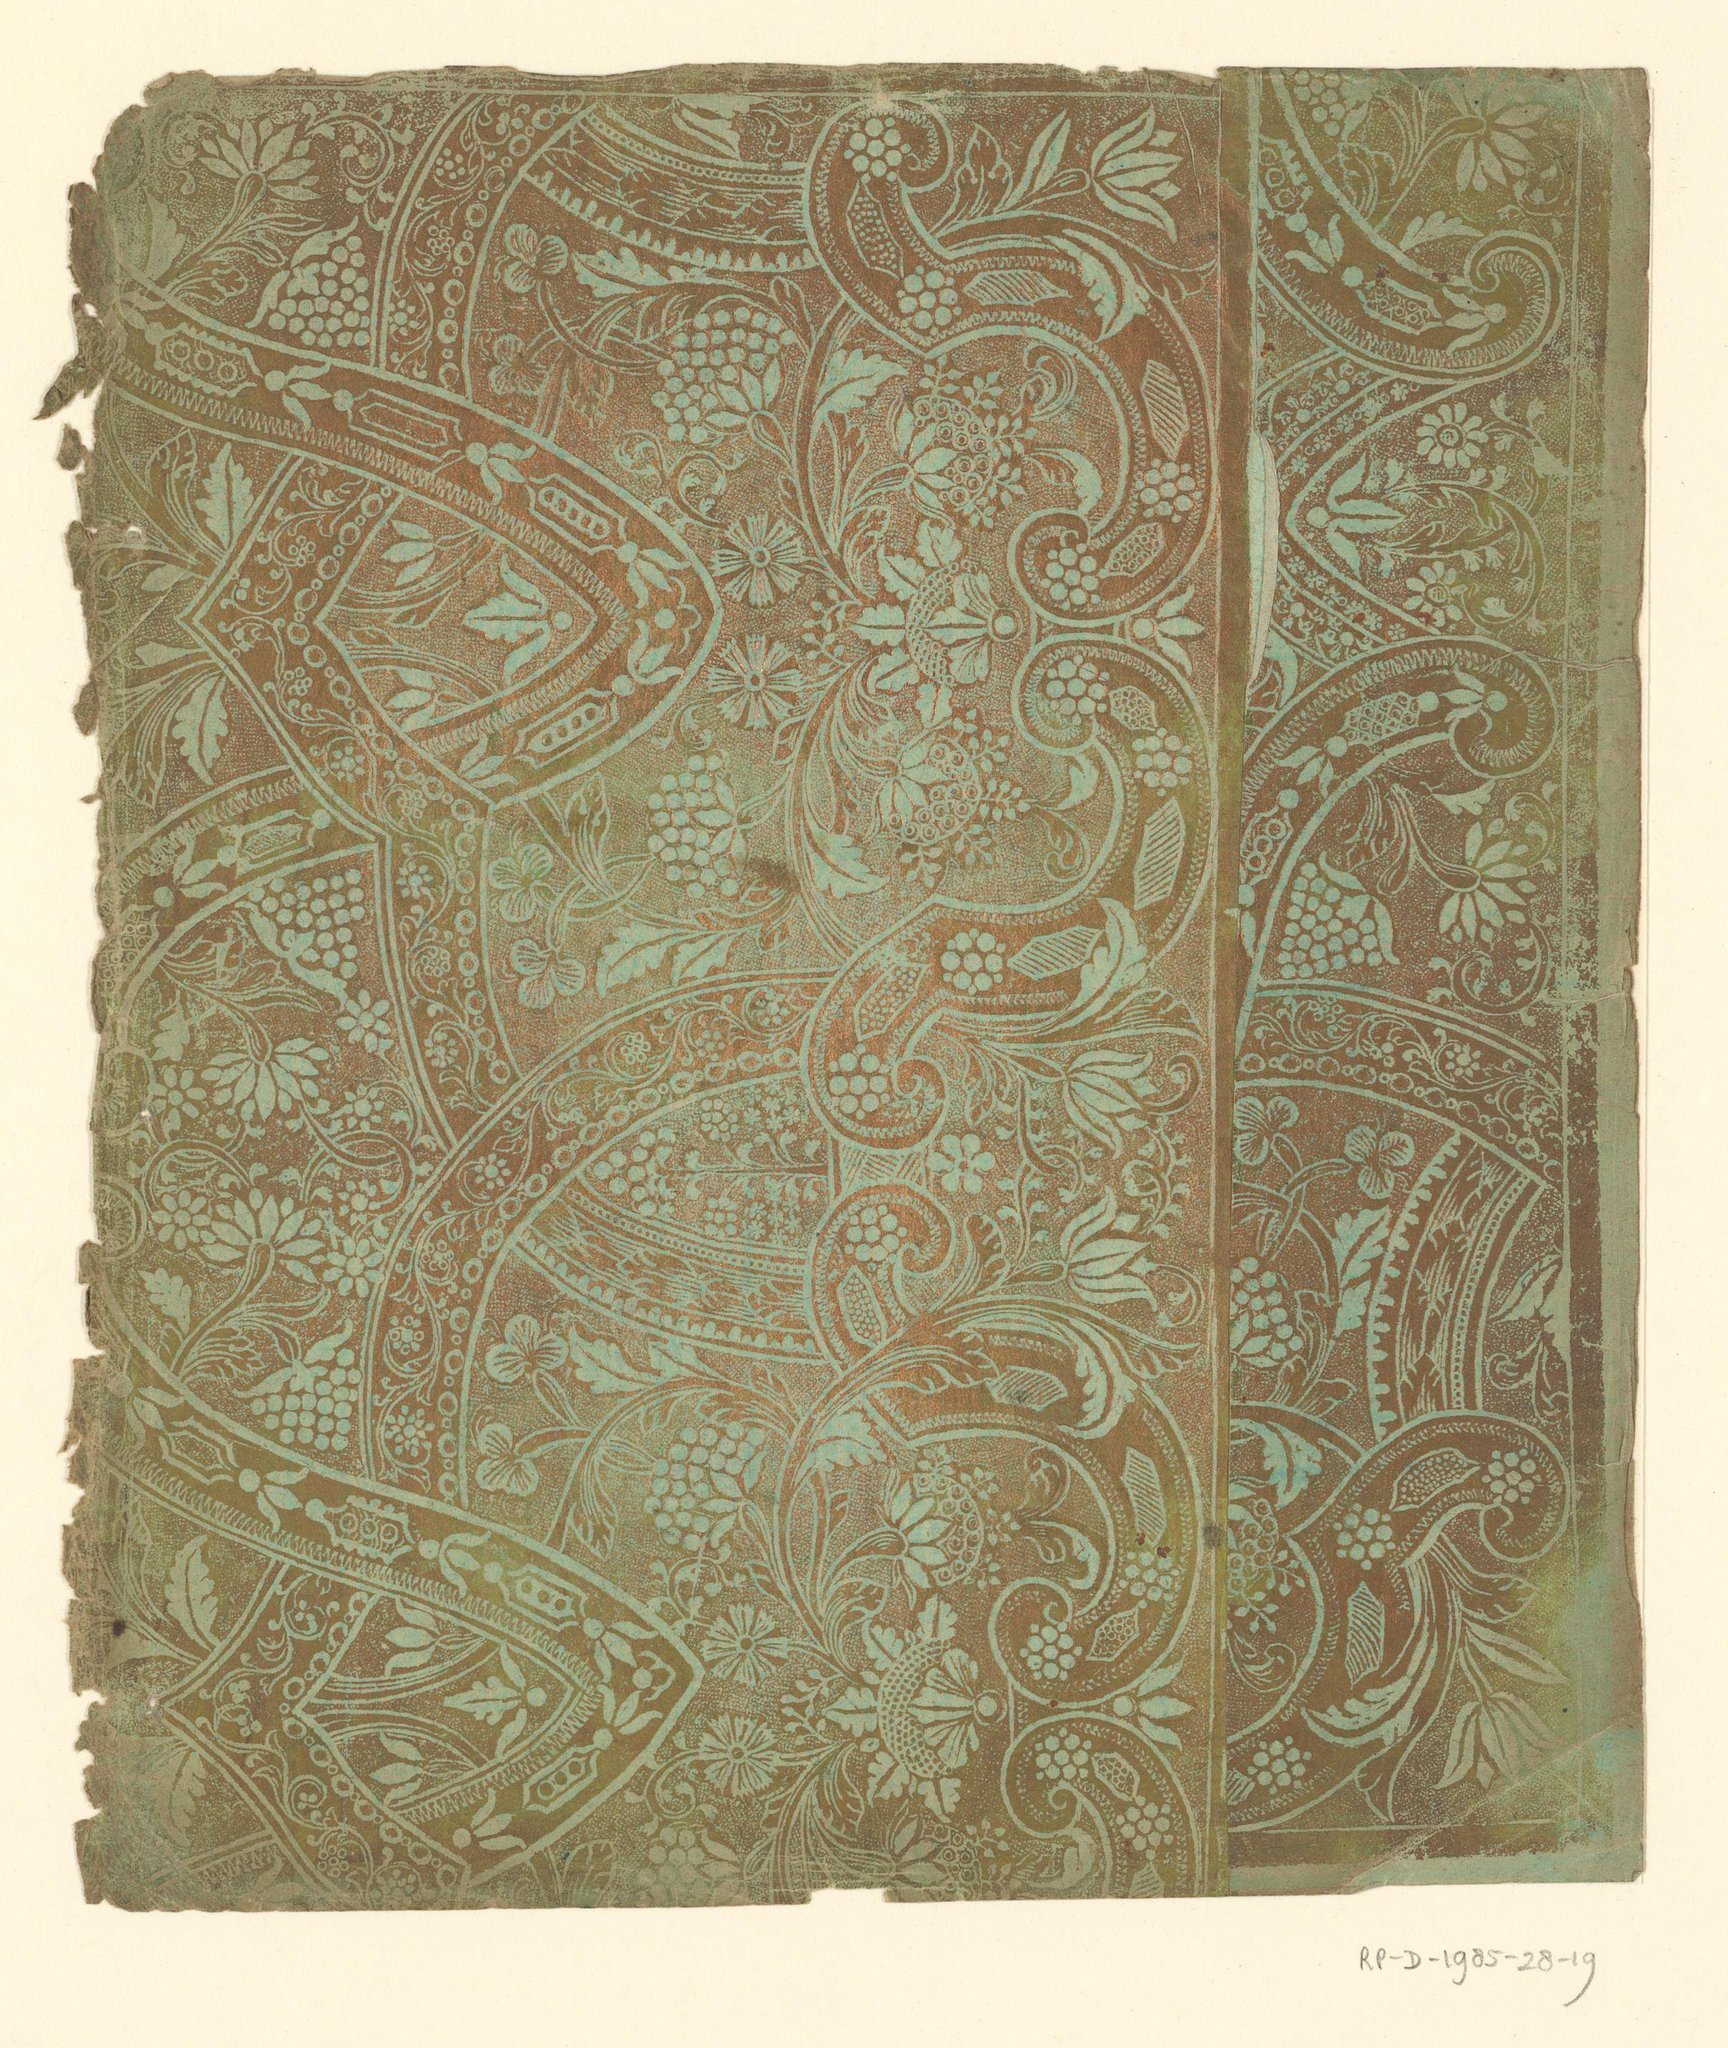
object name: wrapper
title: Blad met bloemen en vruchten met over elkaar slingerende banden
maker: Anonymous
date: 1700-1850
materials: gold leaf, paint, paper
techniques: relief print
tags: ornament derived from plant forms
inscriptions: collector's mark: Lugt 2760, collector's mark: Lugt 2228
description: Blad met bloemen en vruchten met over elkaar slingerende banden gevuld met bloemen, vruchten en andere motieven. Helft van een omslag.